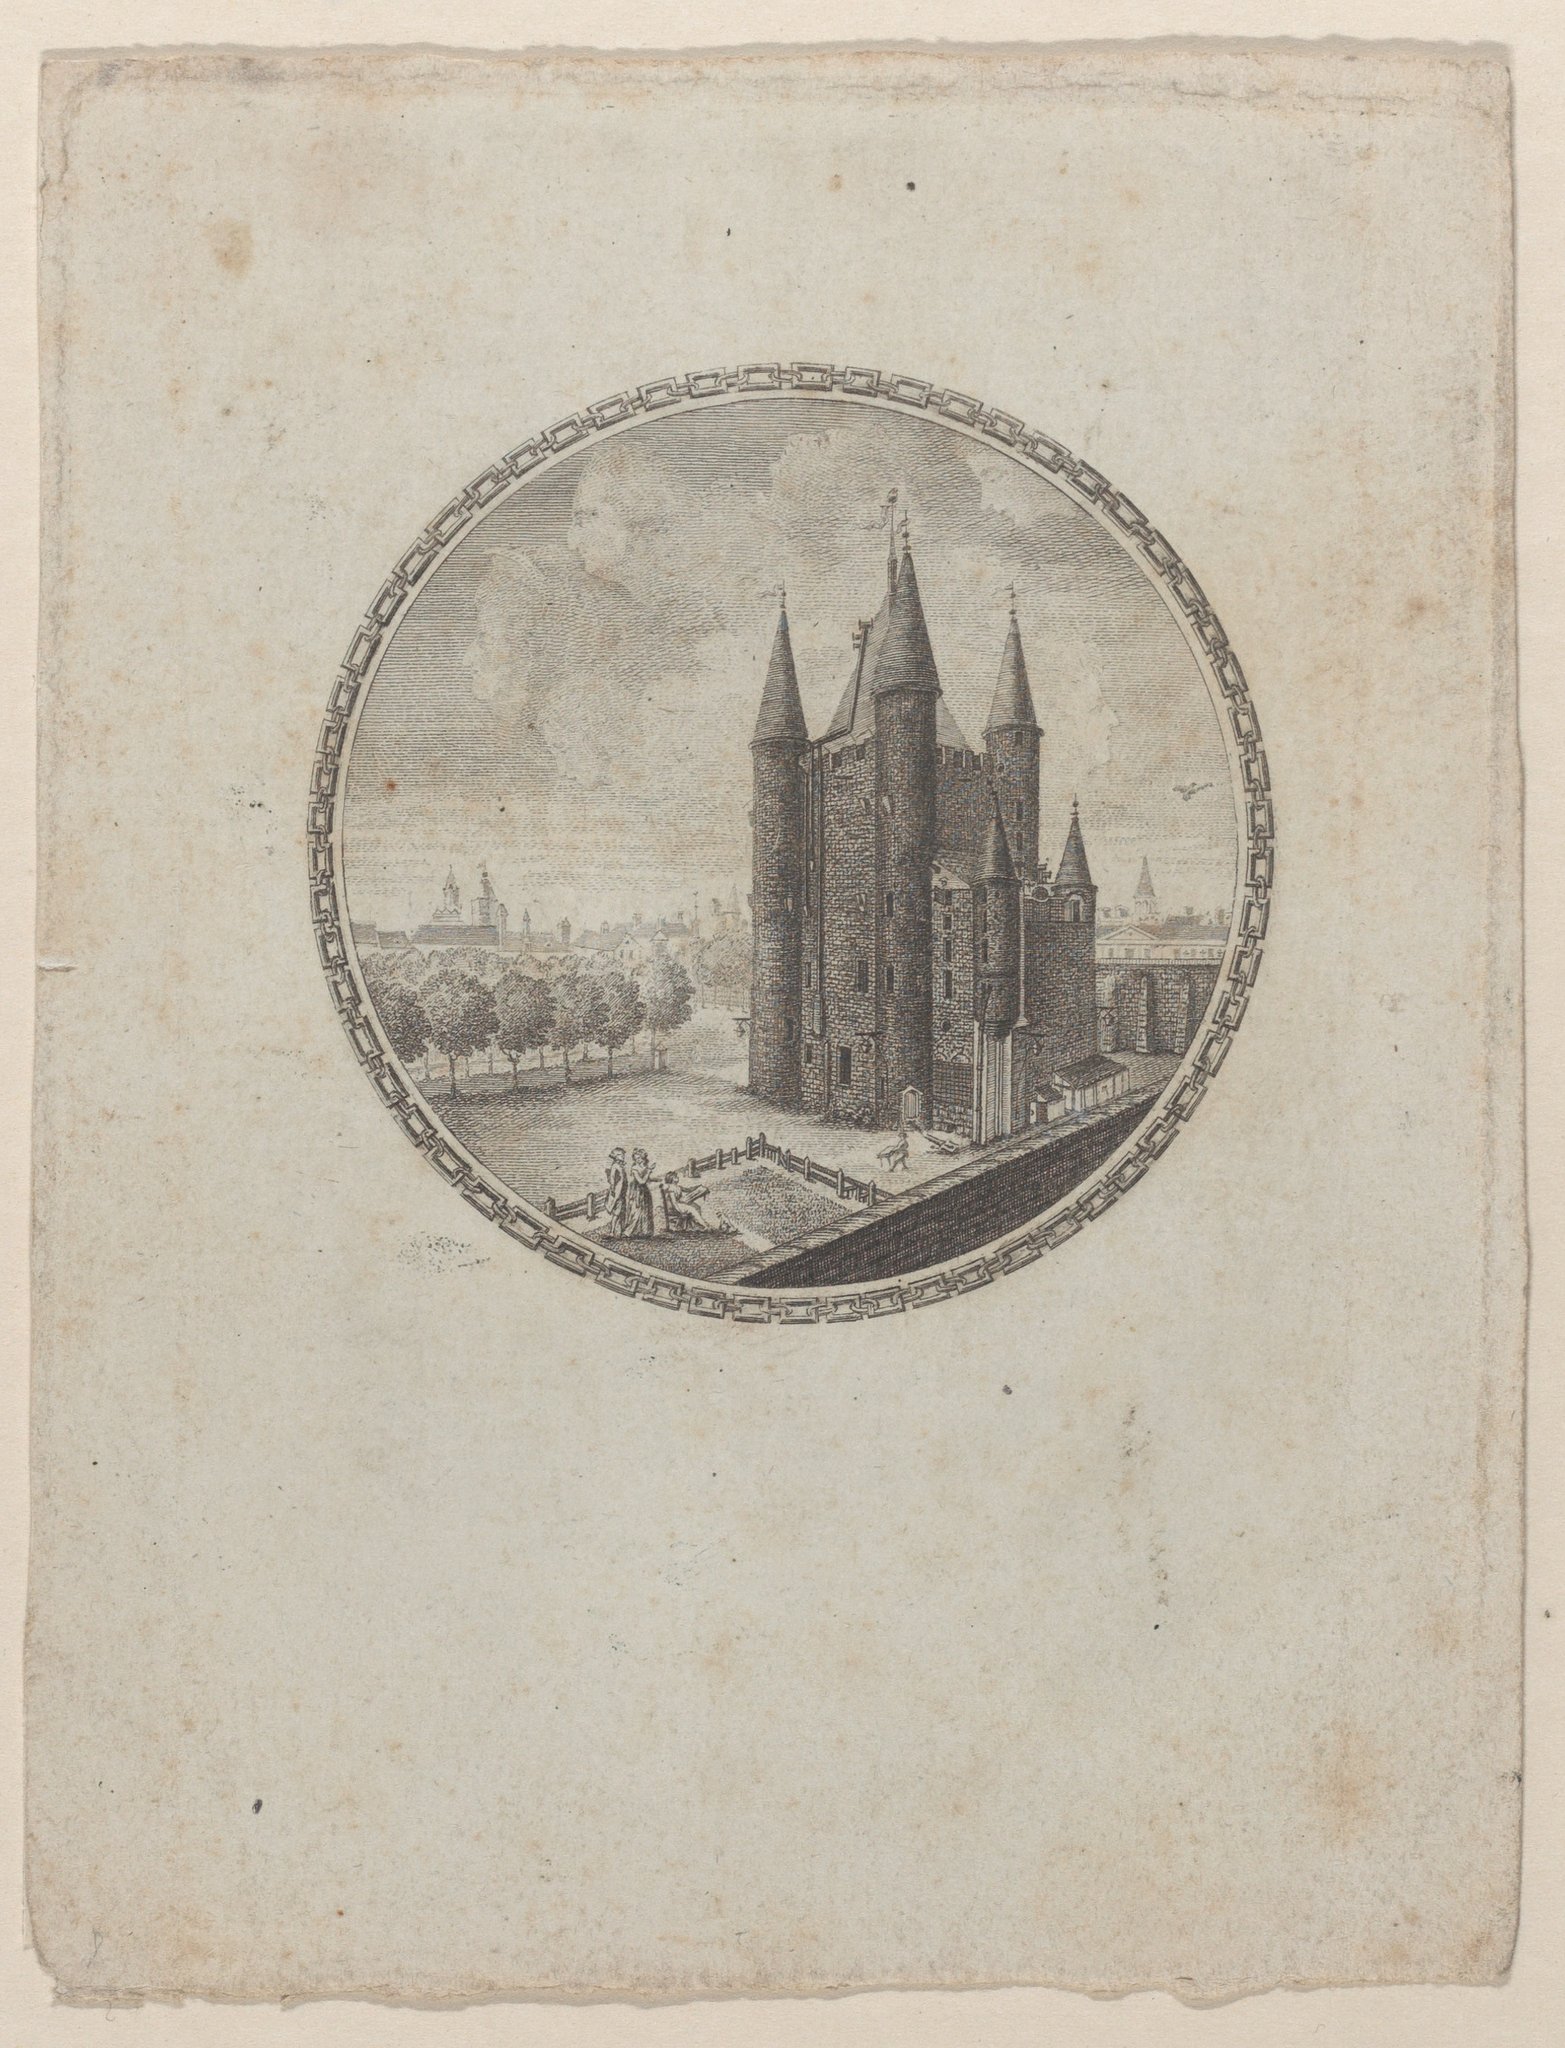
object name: print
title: Circular view of the Conciergerie with hidden silhouettes of the Royal family in the clouds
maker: Anonymous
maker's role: artist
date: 1701-1800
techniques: etching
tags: louis xvi,marie antoinette